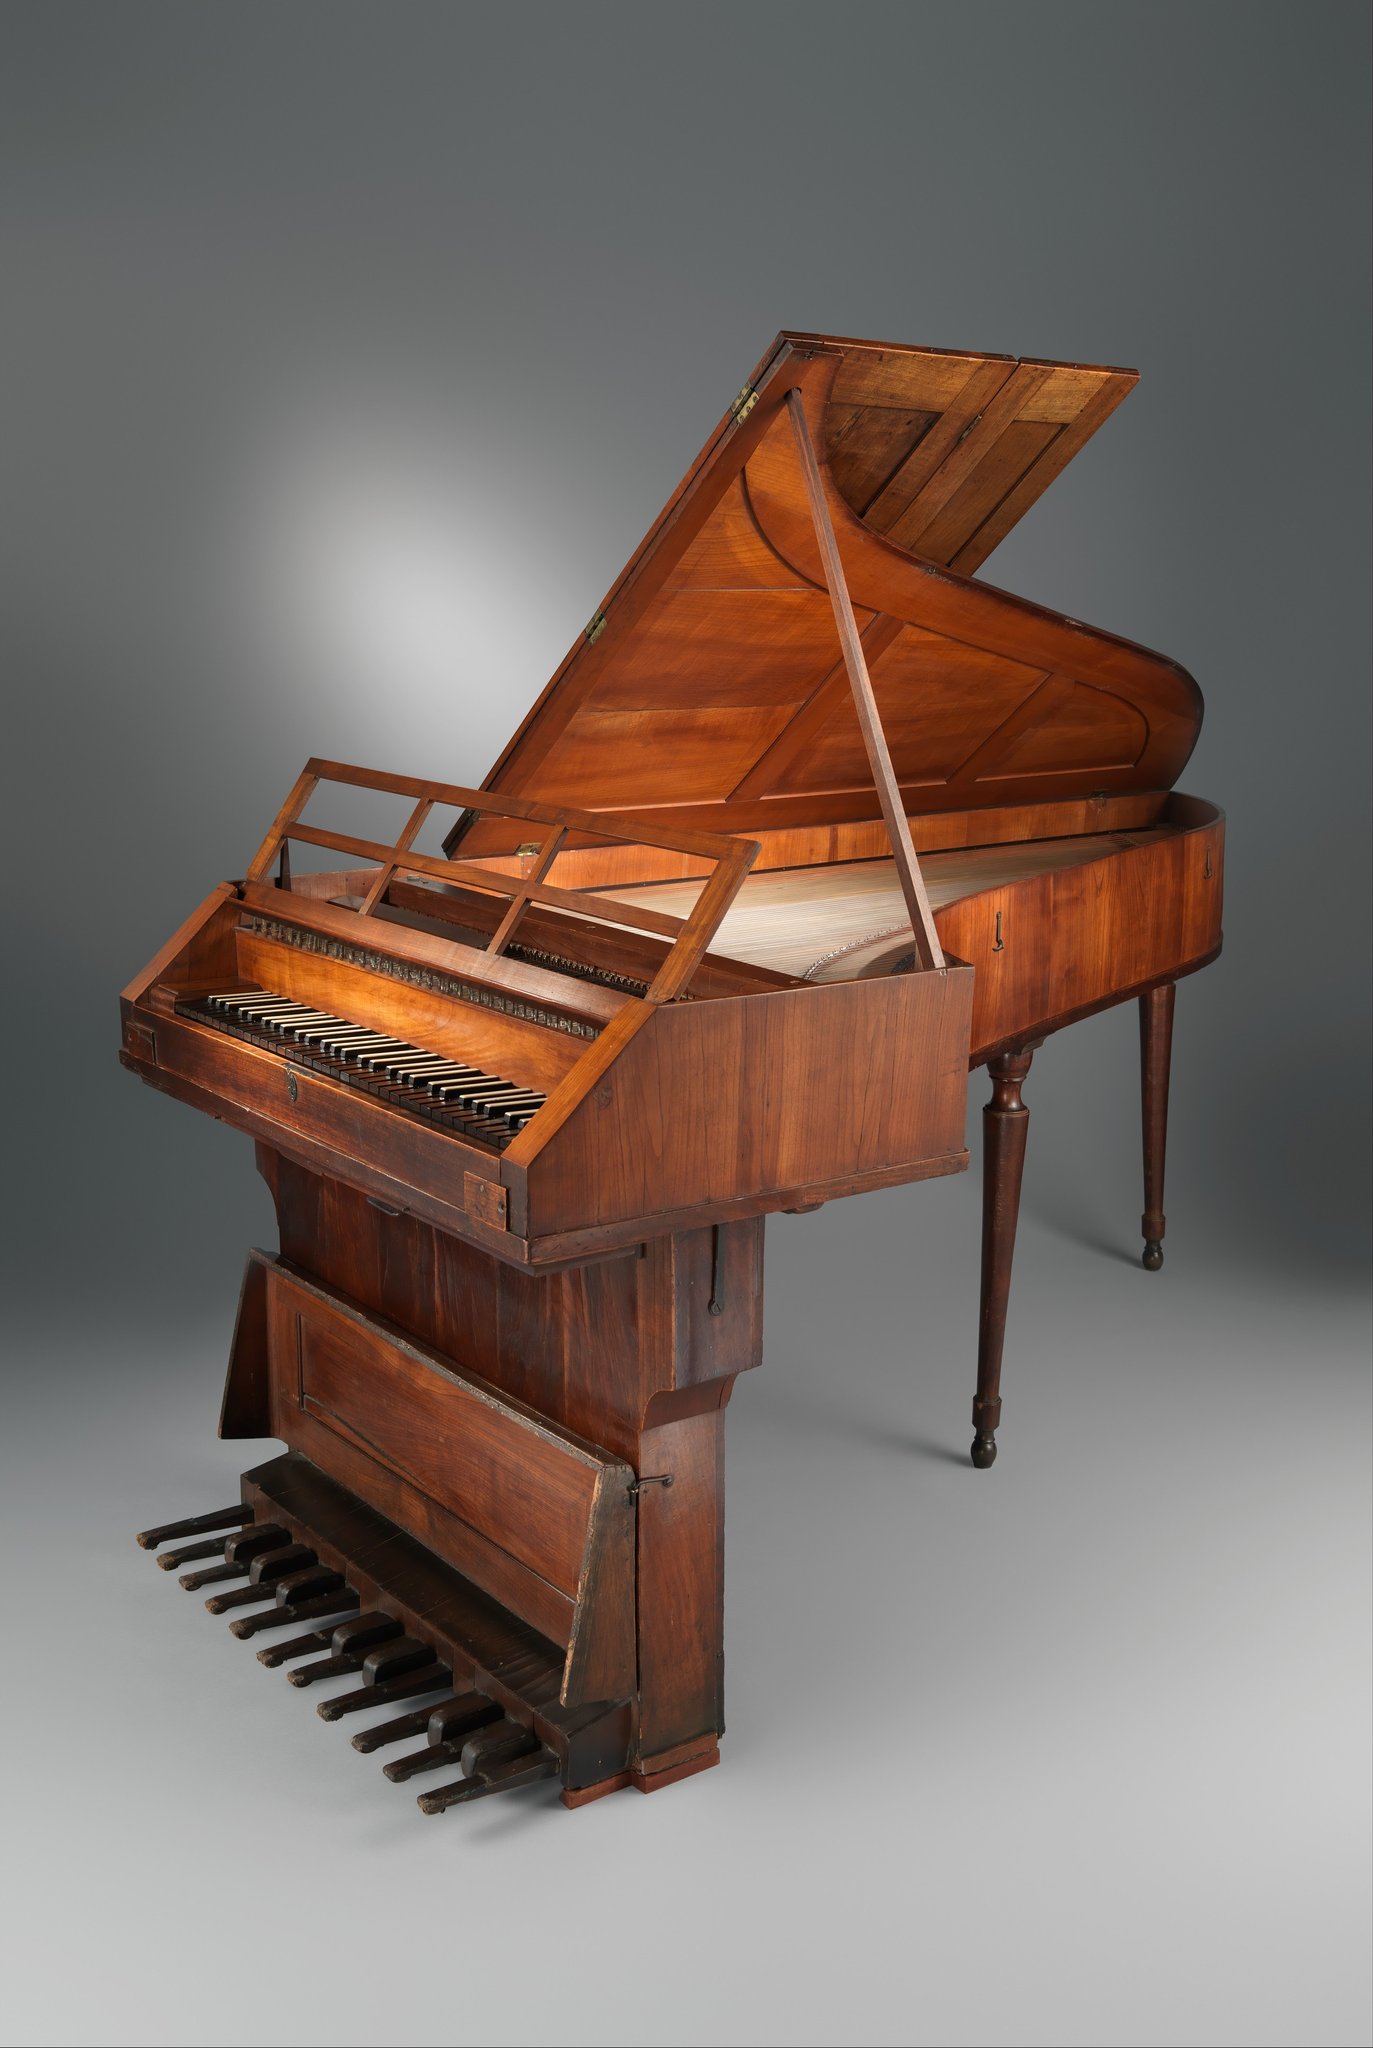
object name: grand piano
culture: austrian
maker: johann schmidt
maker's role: maker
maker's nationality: austrian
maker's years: 1757-1804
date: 1790-1795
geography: austria